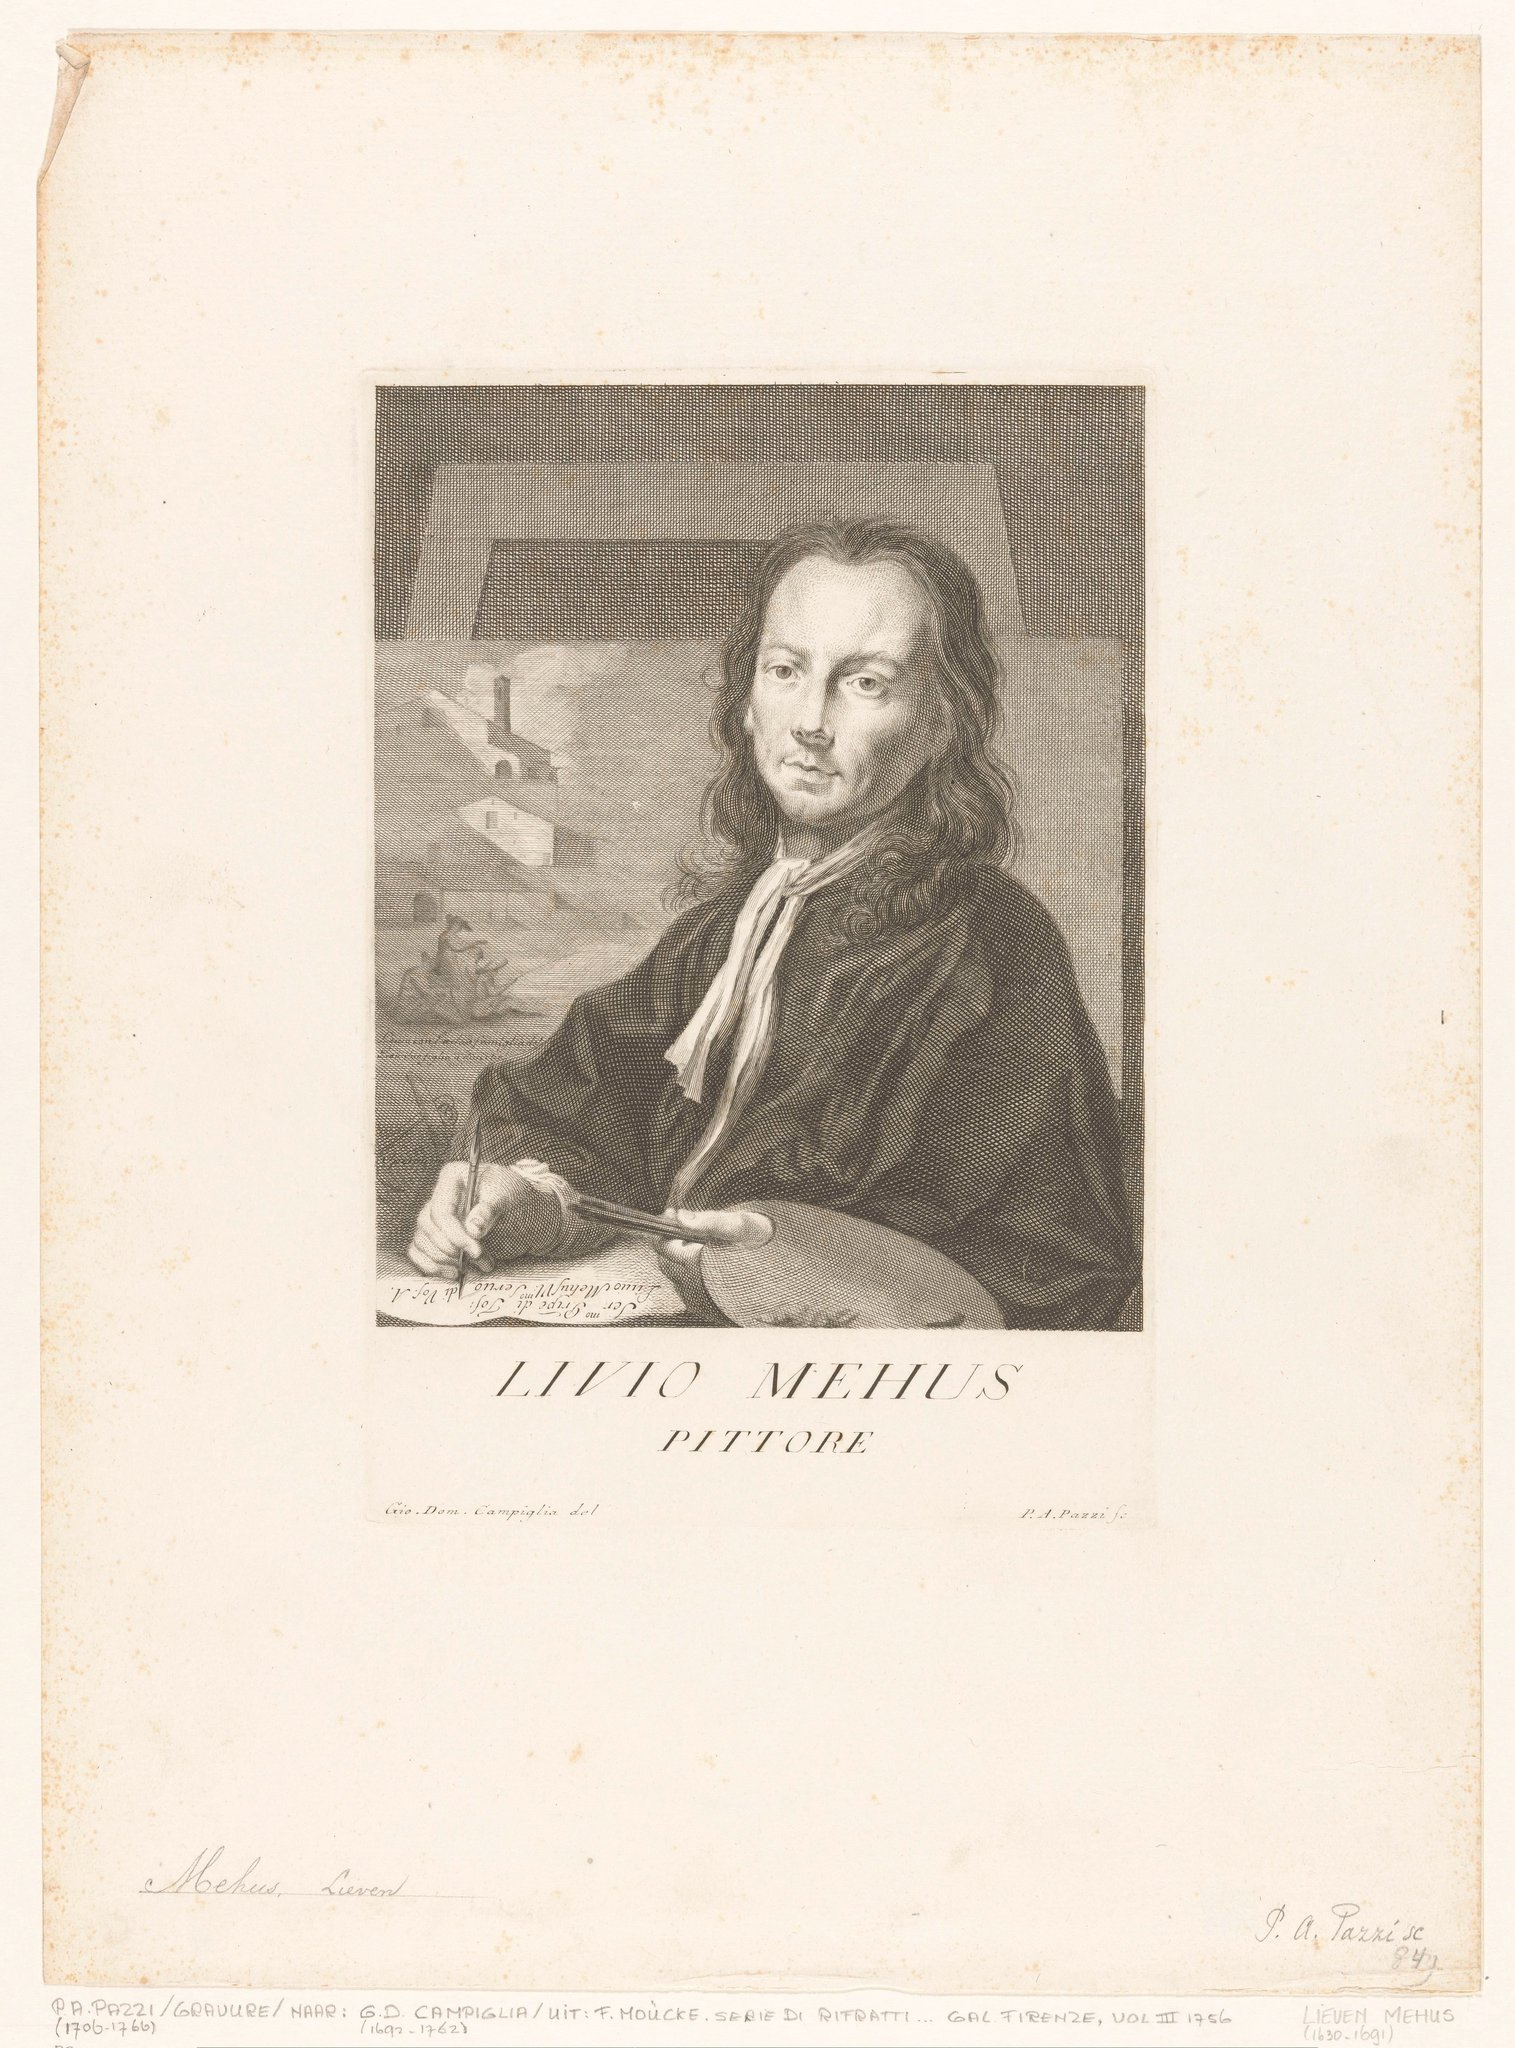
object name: book illustration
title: Portretten van kunstenaars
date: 1752-1762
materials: paper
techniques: engraving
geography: italy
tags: print maker, draughtsman, lieven mehus, historical persons, portrait, self-portrait of painter, tools, implements of painter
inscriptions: collector's mark: ‘RIJKS / MUSM’, collector's mark: Lugt 2760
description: Prent naar geschilderd zelfportret van Lieven Mehus in de Galleria degli Uffizi te Florence (inv.nr. 1651). Prent uit: Moücke, Francesco. Serie di ritratti degli eccellenti pittori dipinti di propria mano, che esistono nell'Imiperial Galleria di Firenze. Florence: 1752-1762, dl. III.